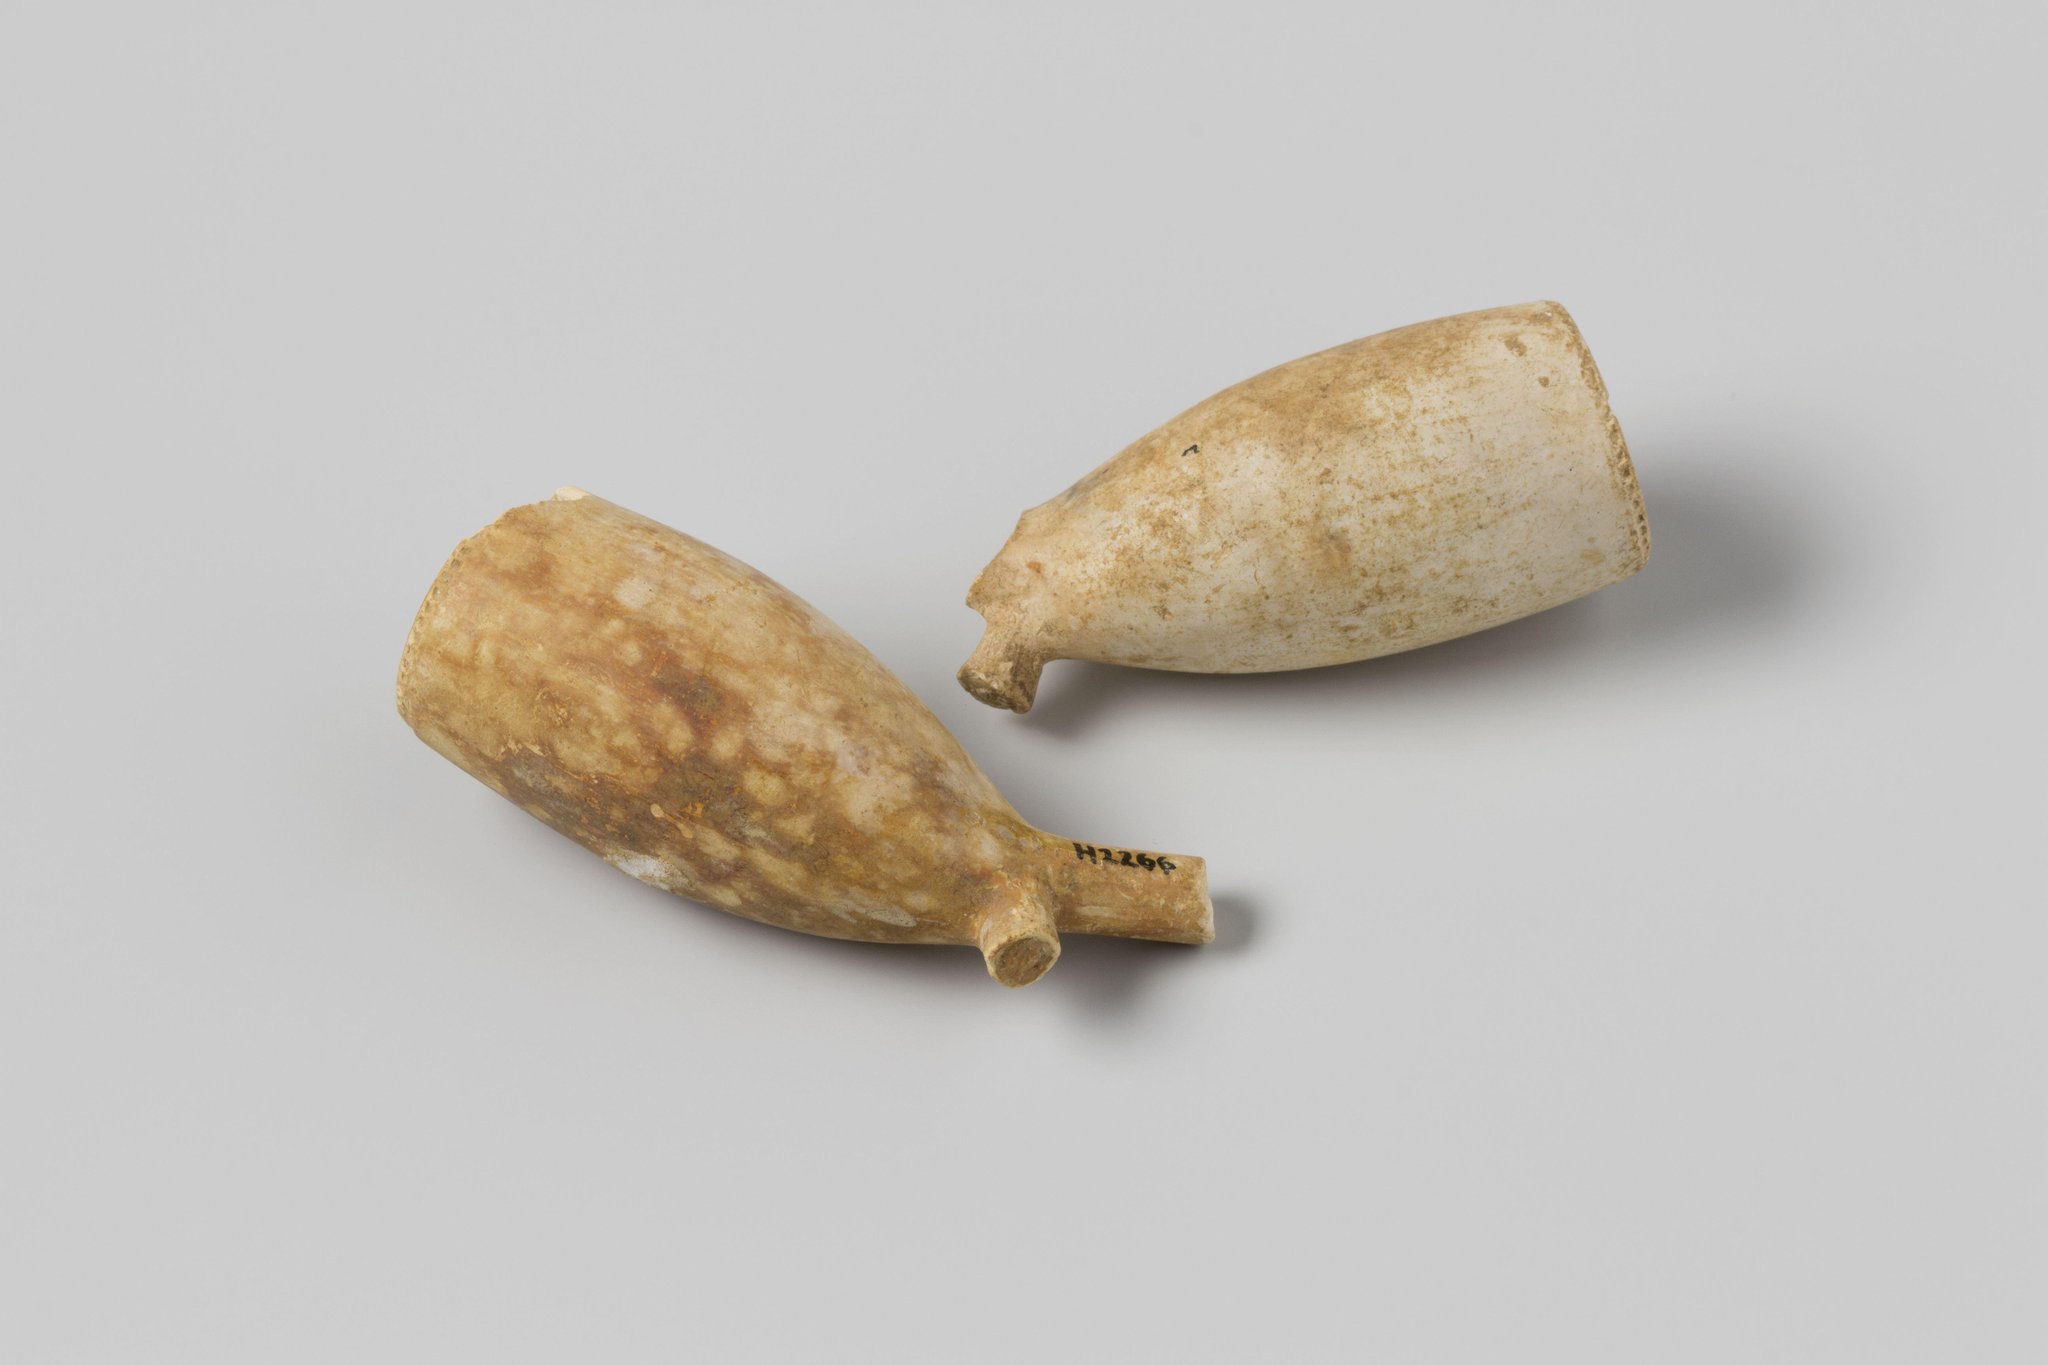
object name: pipe bowl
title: Pijpenkoppen uit het wrak van de Oost-Indiëvaarder Hollandia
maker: Anonymous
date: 1700-1743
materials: clay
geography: netherlands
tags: verenigde oostindische compagnie, hollandia (schip), annet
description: Pipe, bowl, heelmark: tobacco's brazier; 2hsm2.